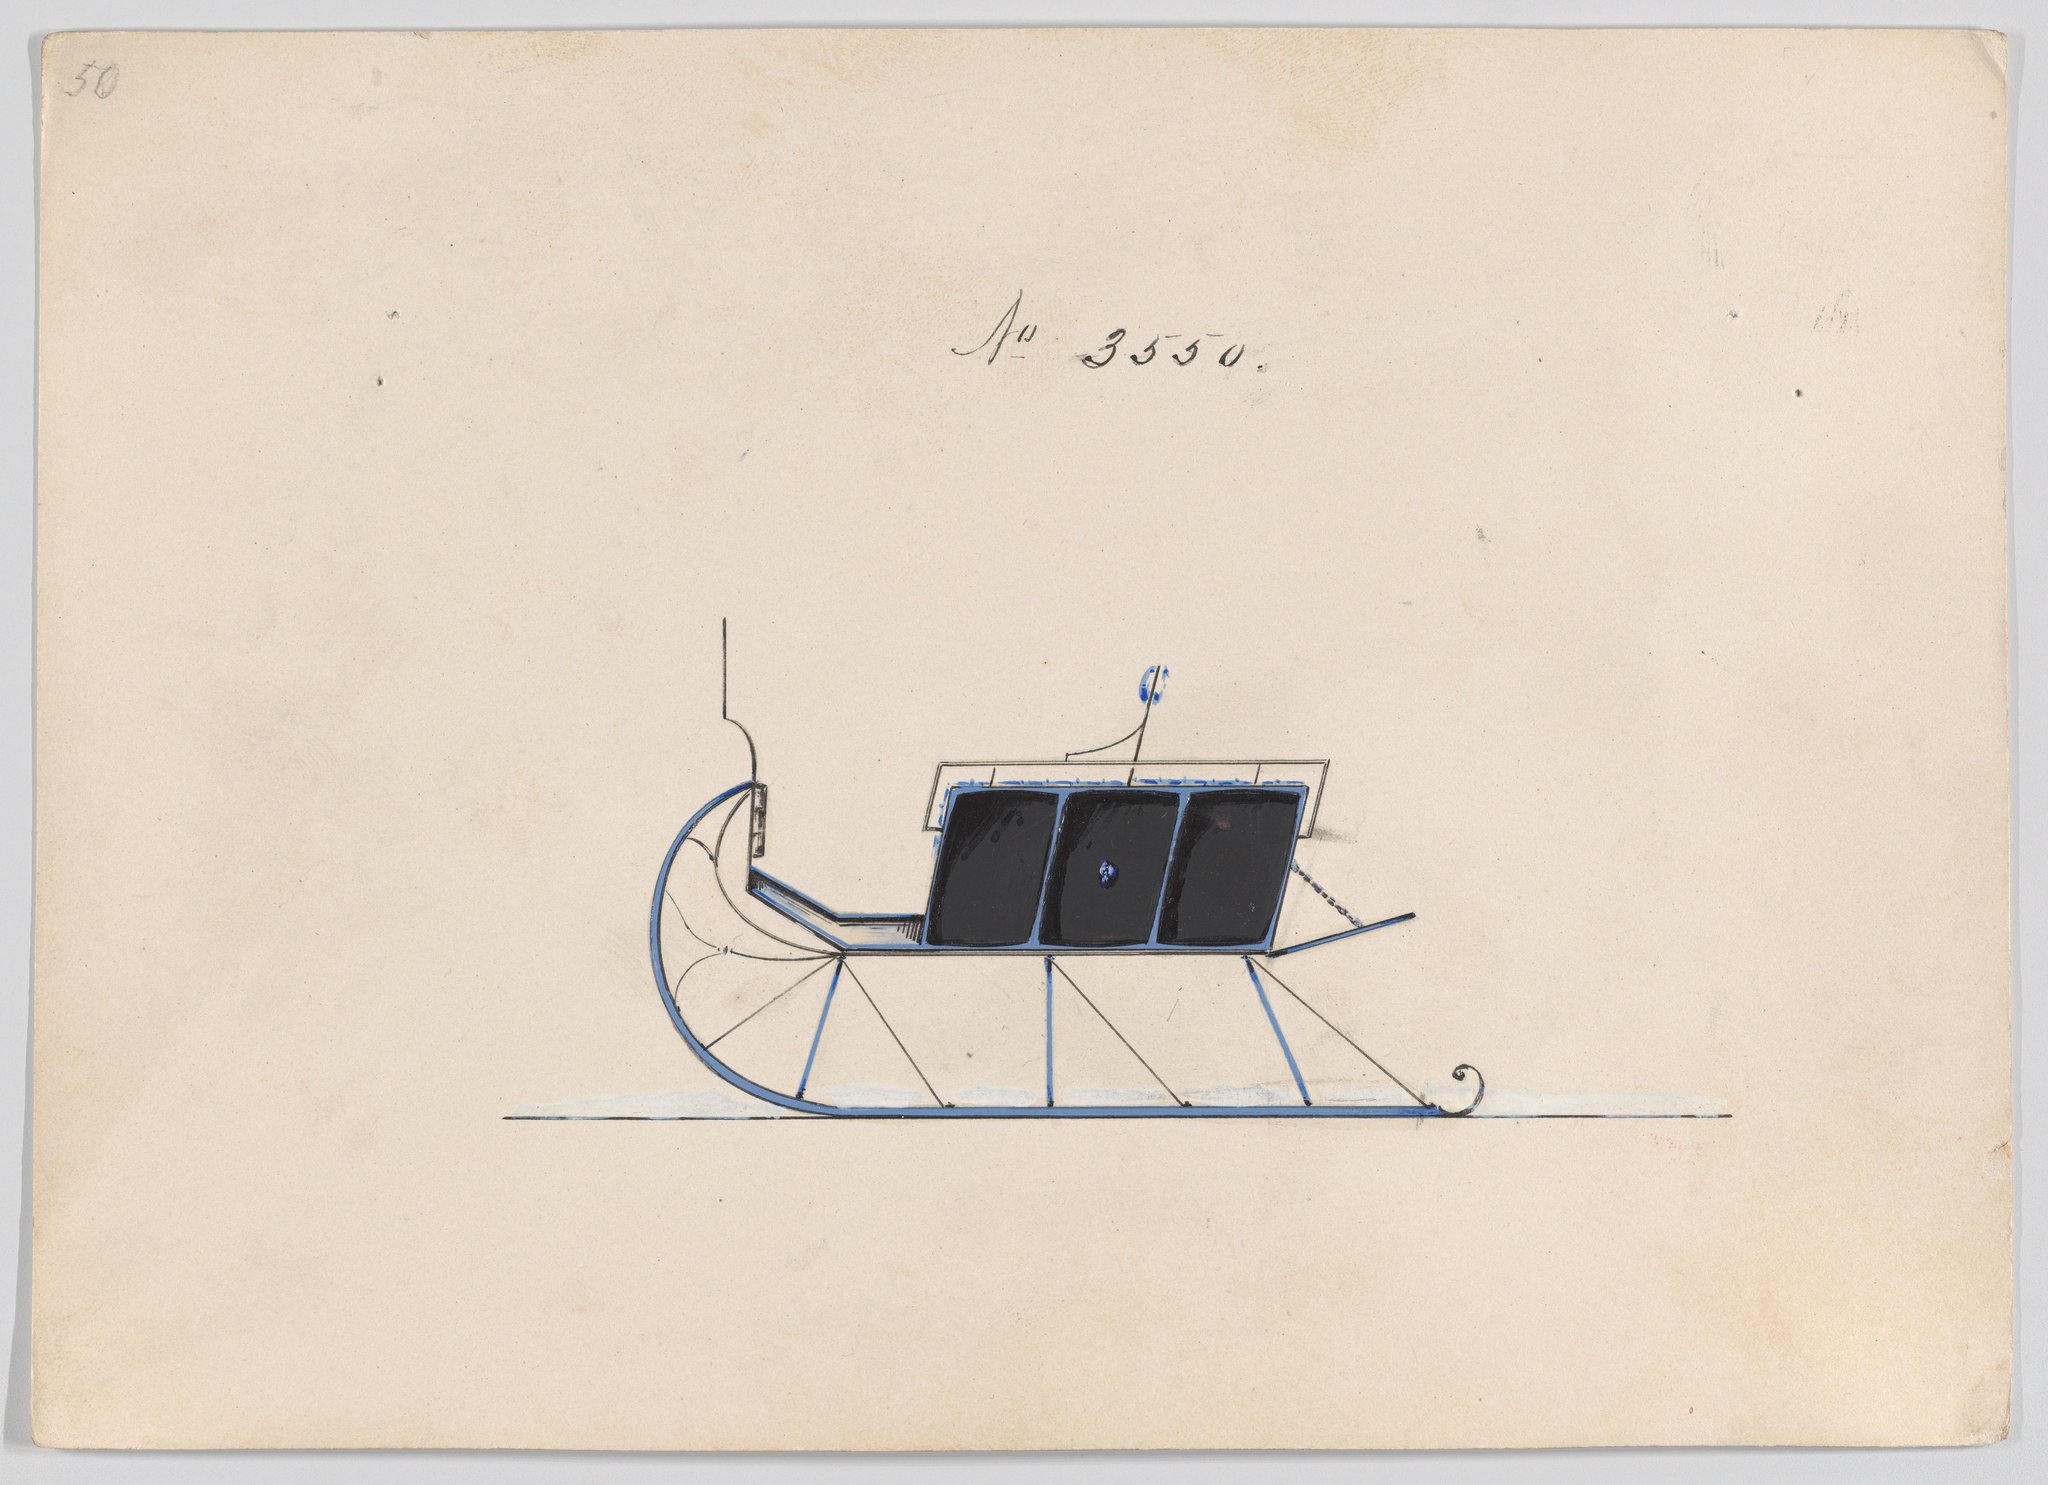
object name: drawing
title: Design for Dos-a-Dos Sleigh, no. 3550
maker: brewster & co.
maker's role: manufacturer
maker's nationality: american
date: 1879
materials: gouache, gum arabic, ink, watercolor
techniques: pen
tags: sleighs